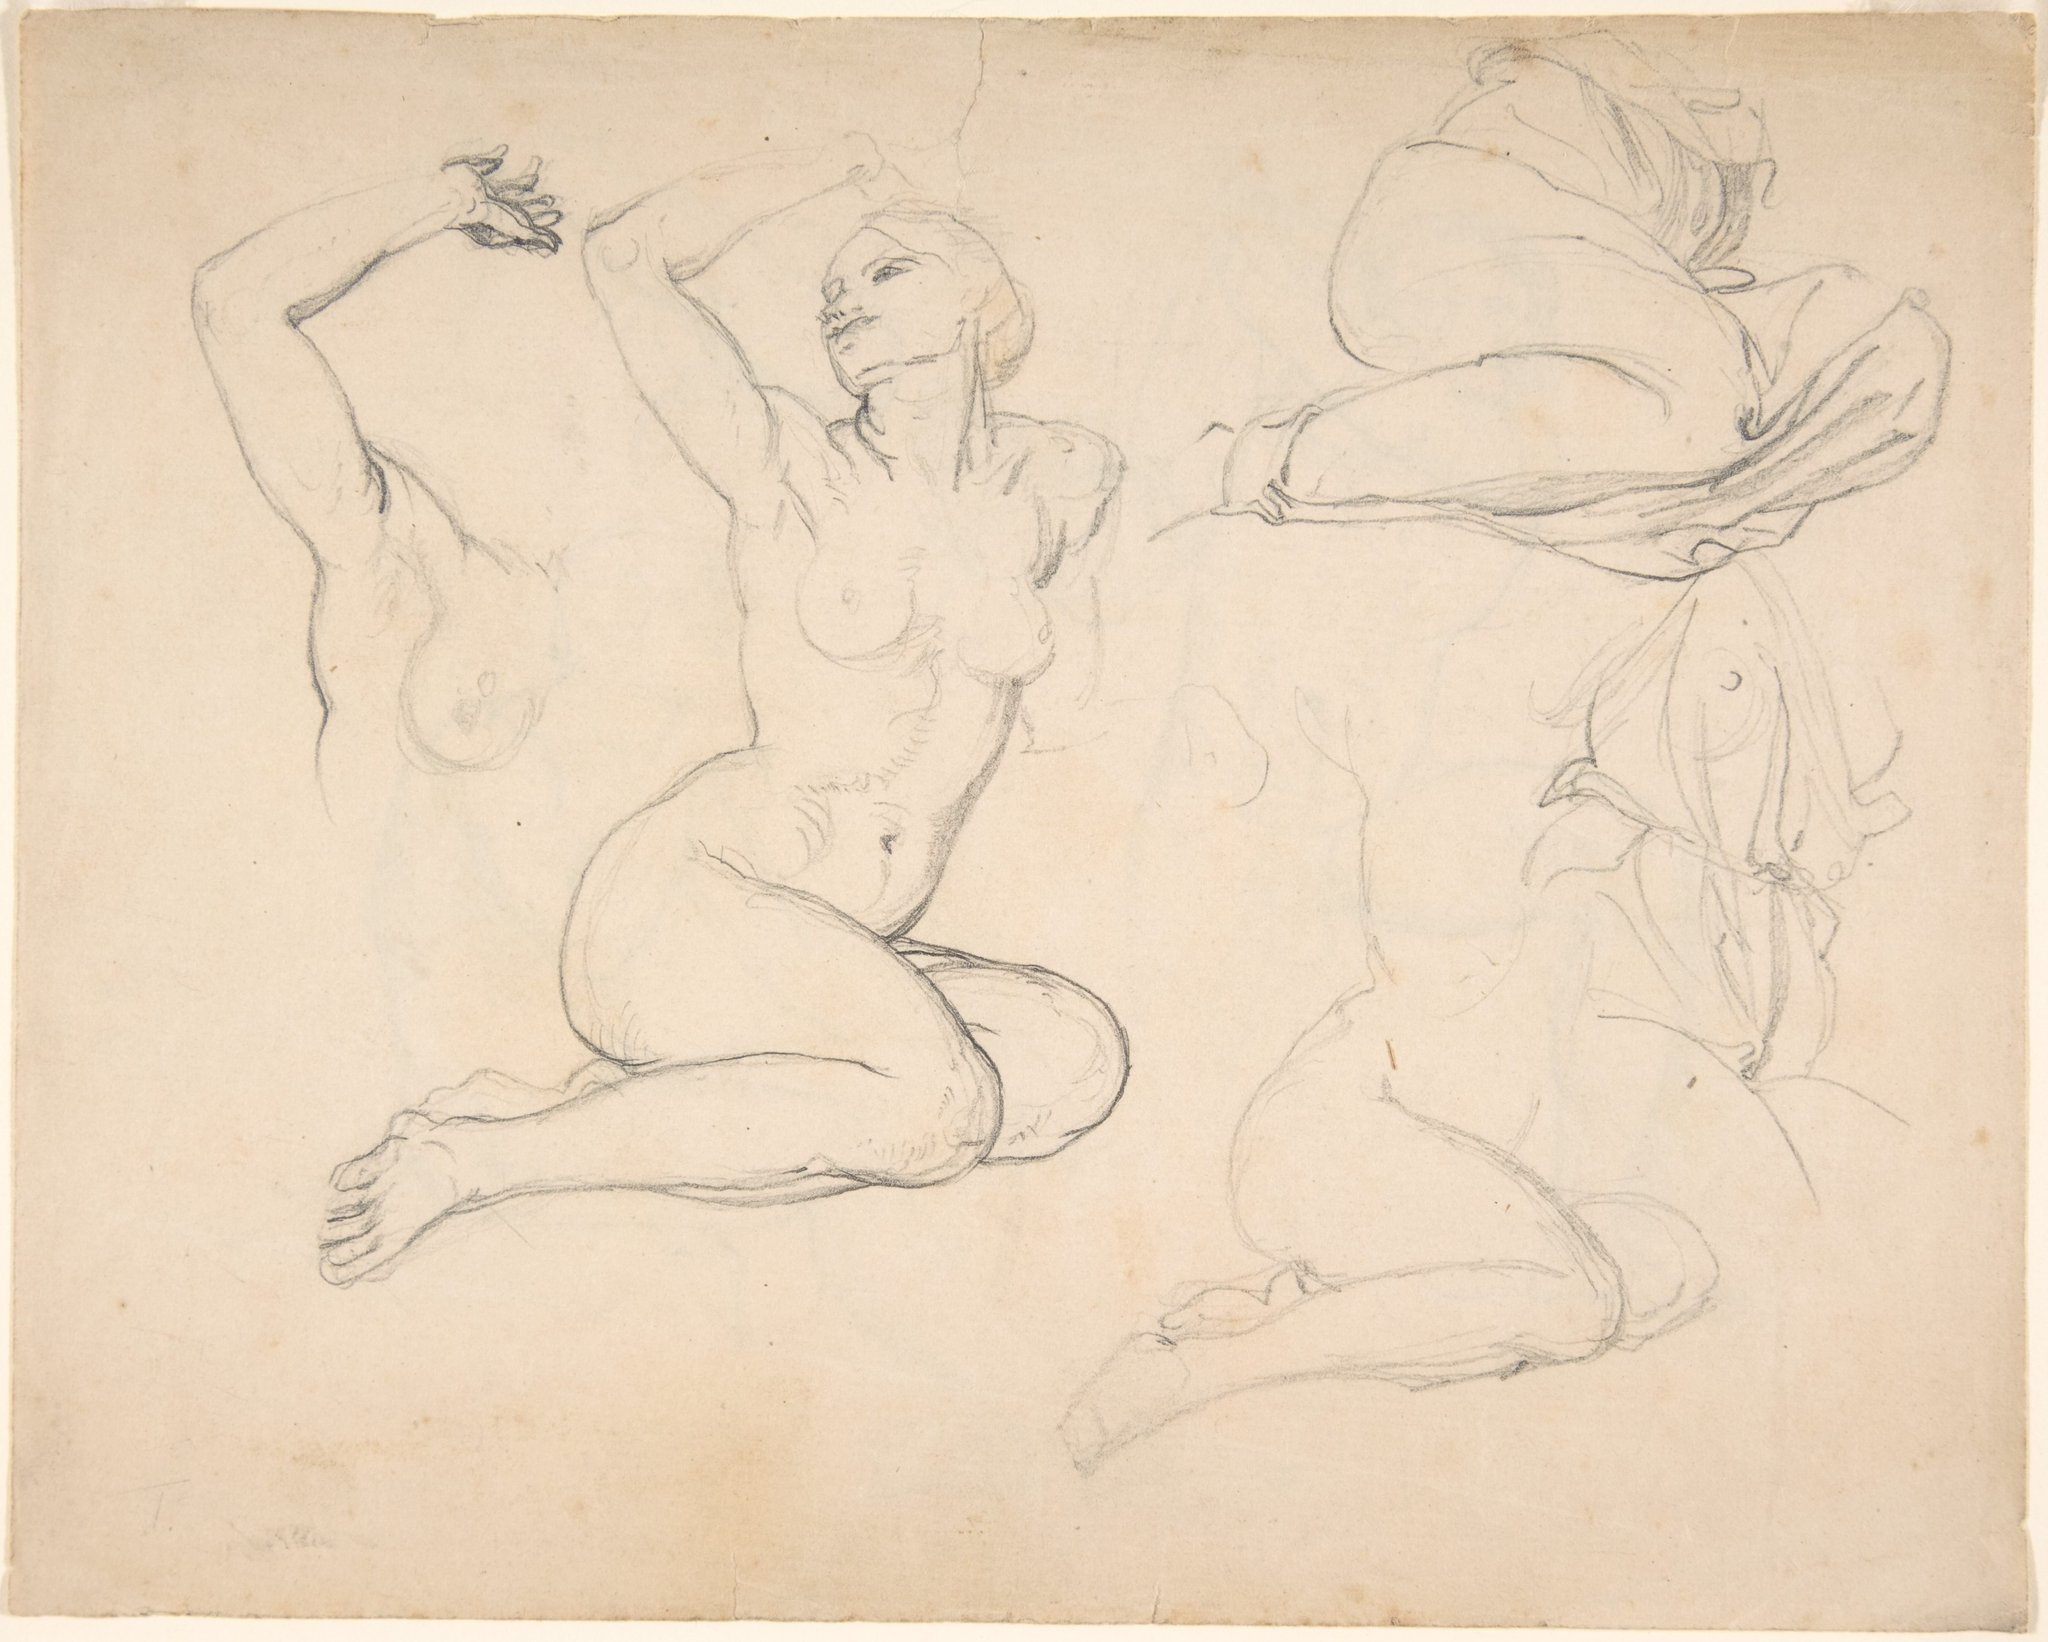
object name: drawing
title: Studies of a Sitting Woman; verso: Studies of Men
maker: eduard julius friedrich bendemann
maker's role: artist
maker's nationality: german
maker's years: 1811-1889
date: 1811-1889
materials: graphite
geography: germany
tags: female nudes